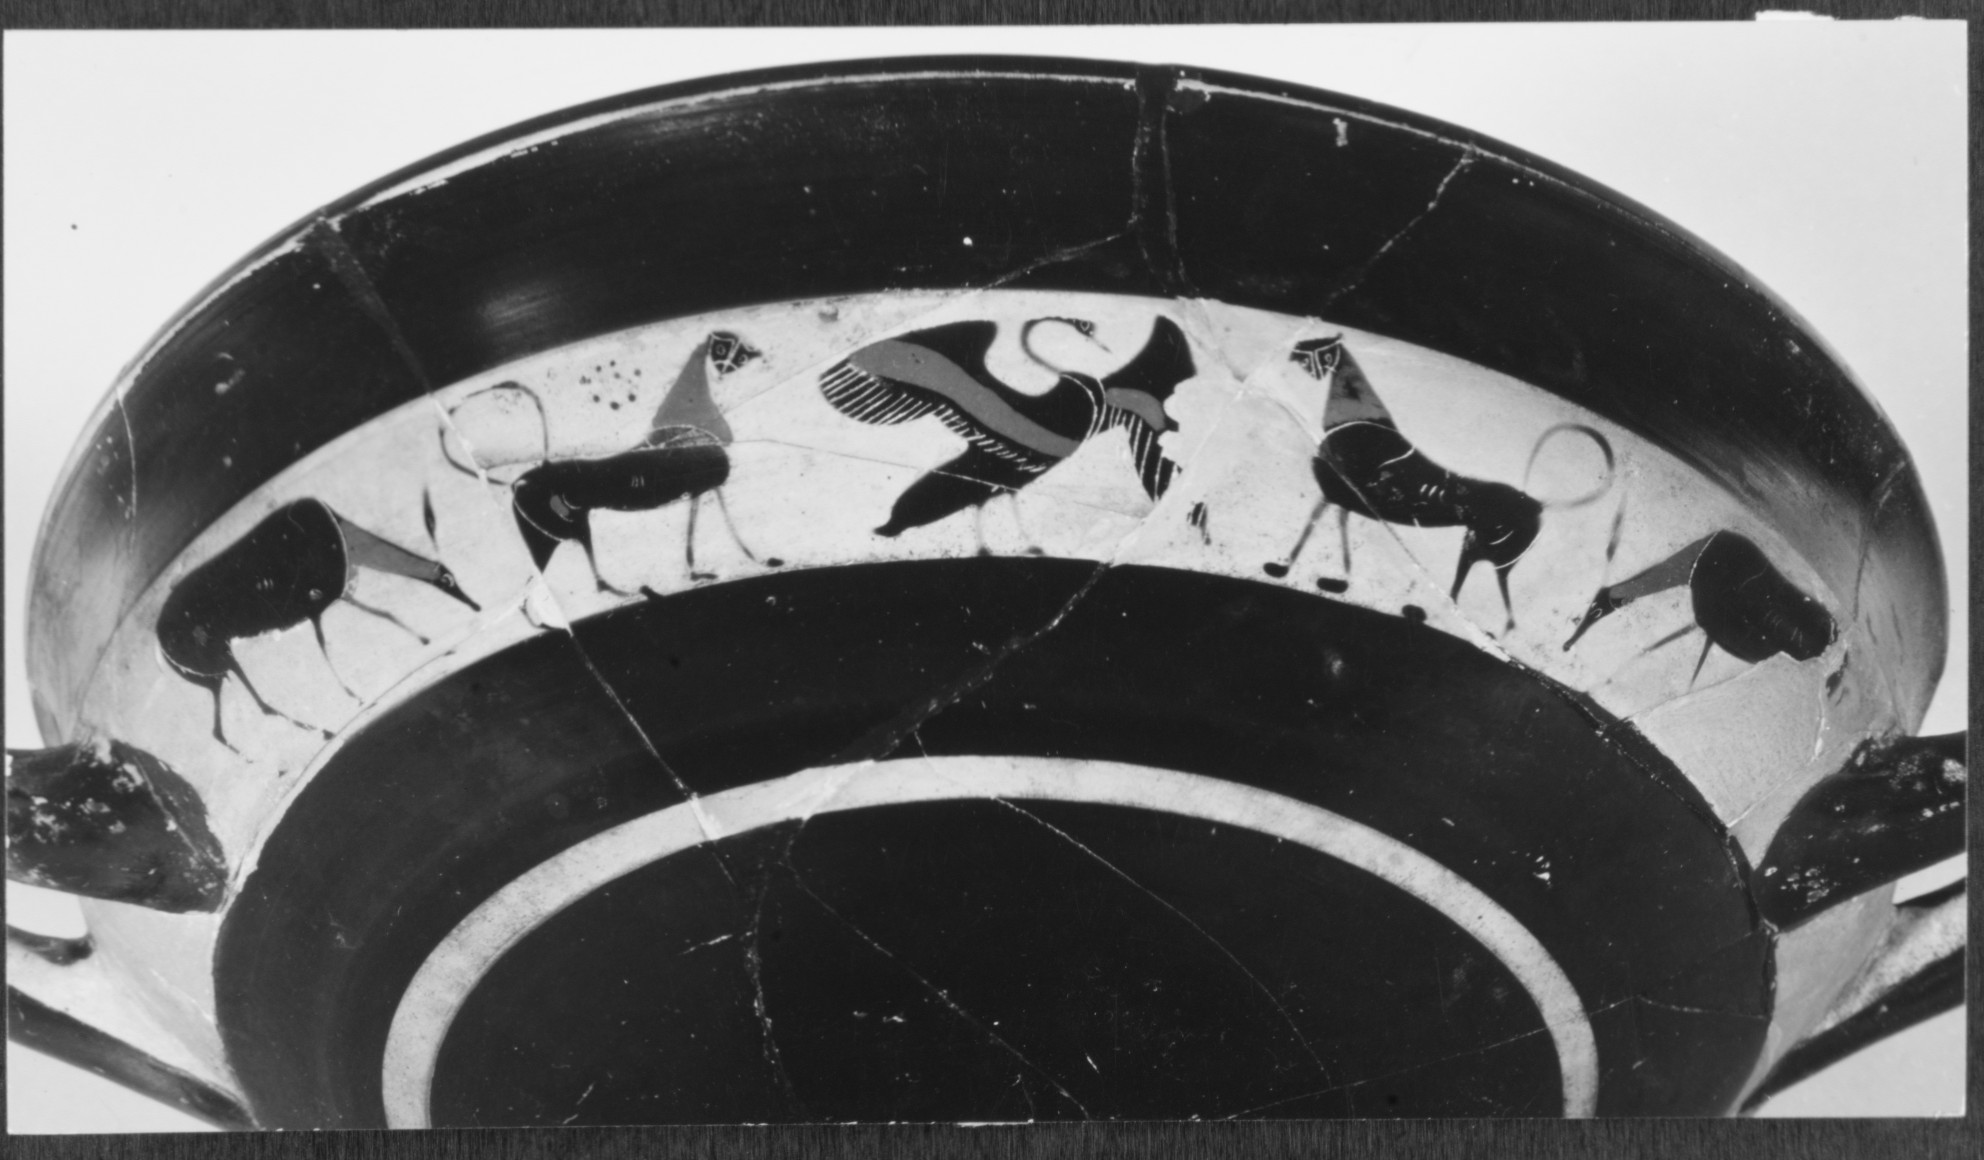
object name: kylix, band cup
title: Kylix, band-cup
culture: greek, attic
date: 550-526 BCE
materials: terracotta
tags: animals,swans